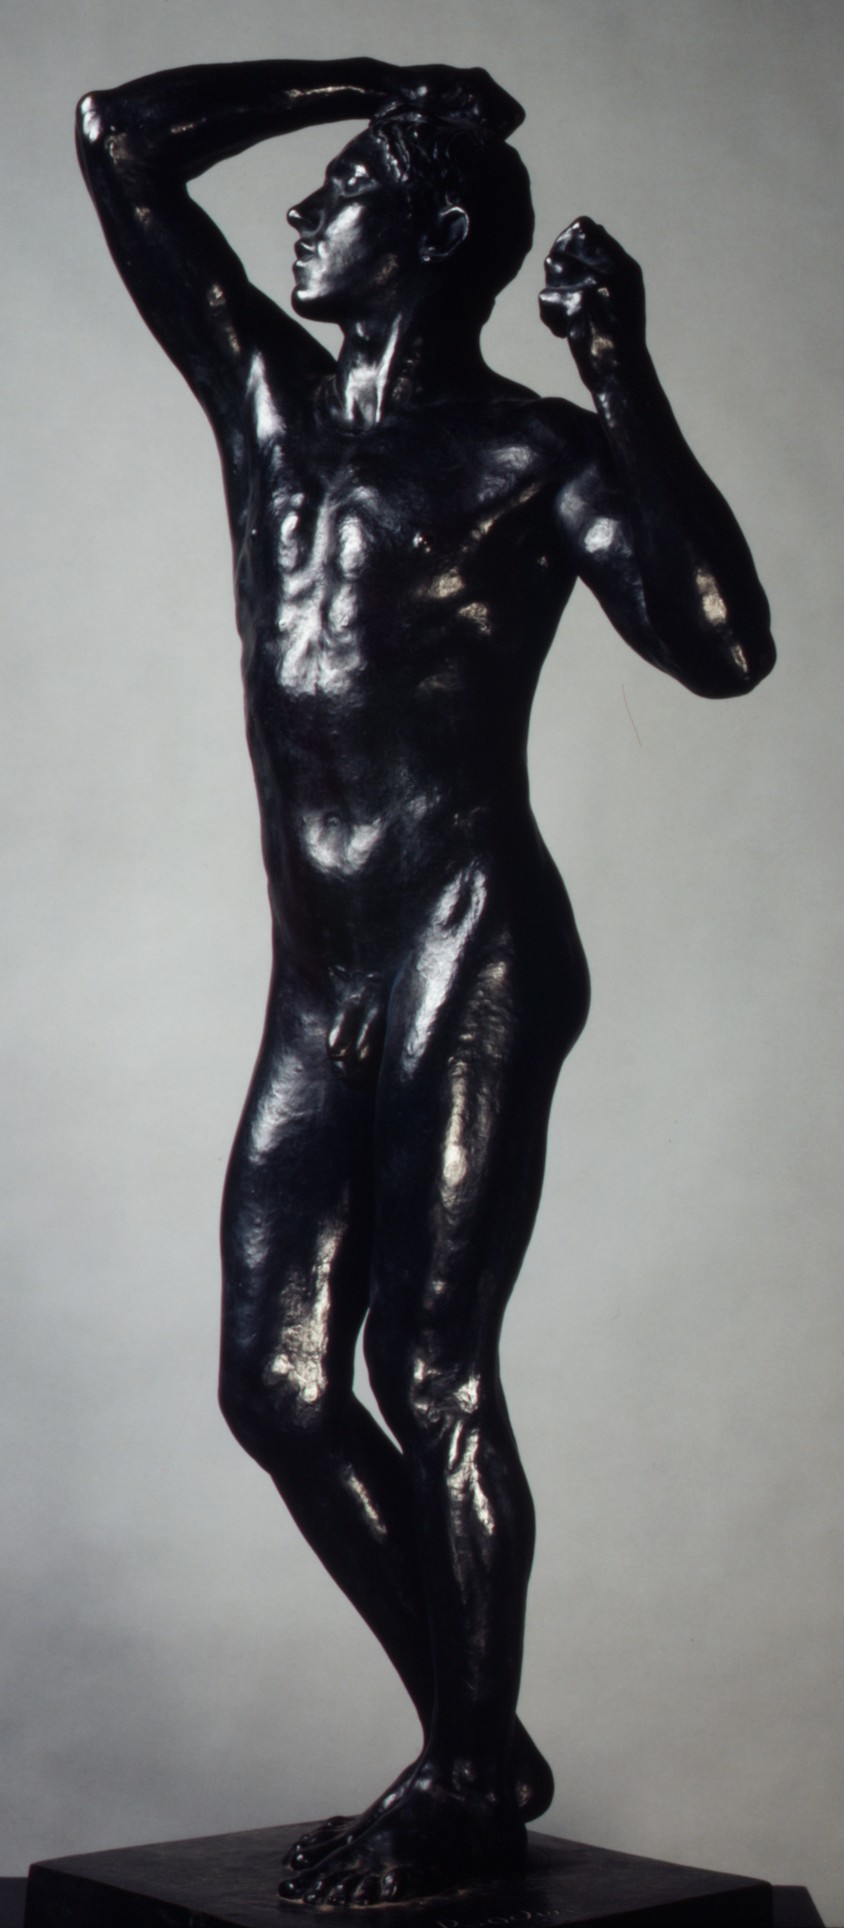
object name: statue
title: The Age of Bronze (L'Age d'airain)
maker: auguste rodin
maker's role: artist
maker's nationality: french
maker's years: 1840-1917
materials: bronze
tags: male nudes